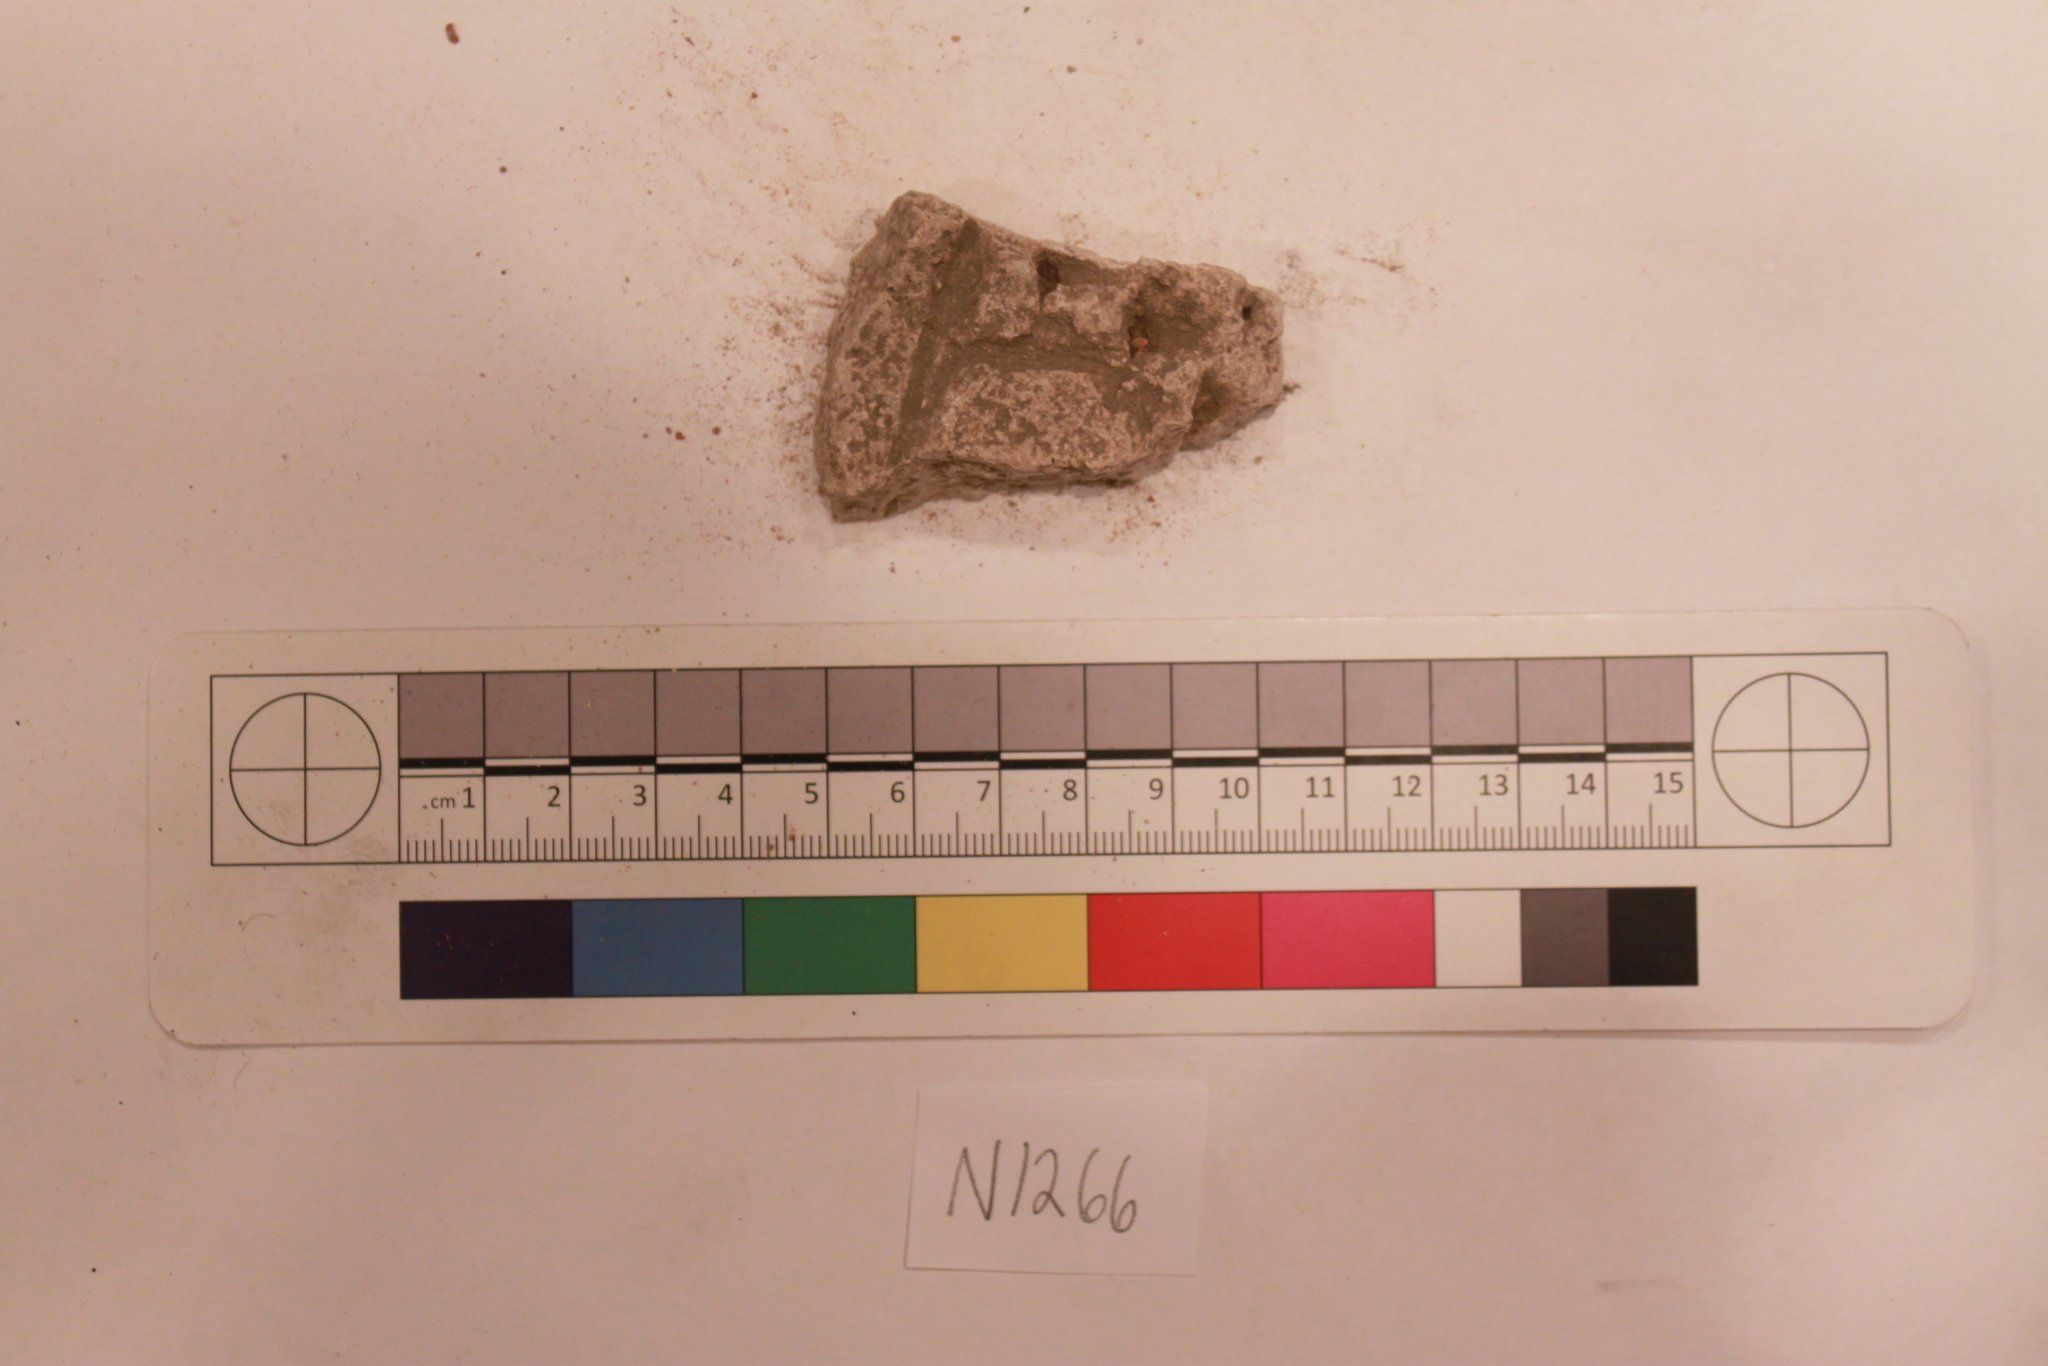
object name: fragment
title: Stucco Fragment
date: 701-1200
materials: plaster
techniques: carving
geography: iran